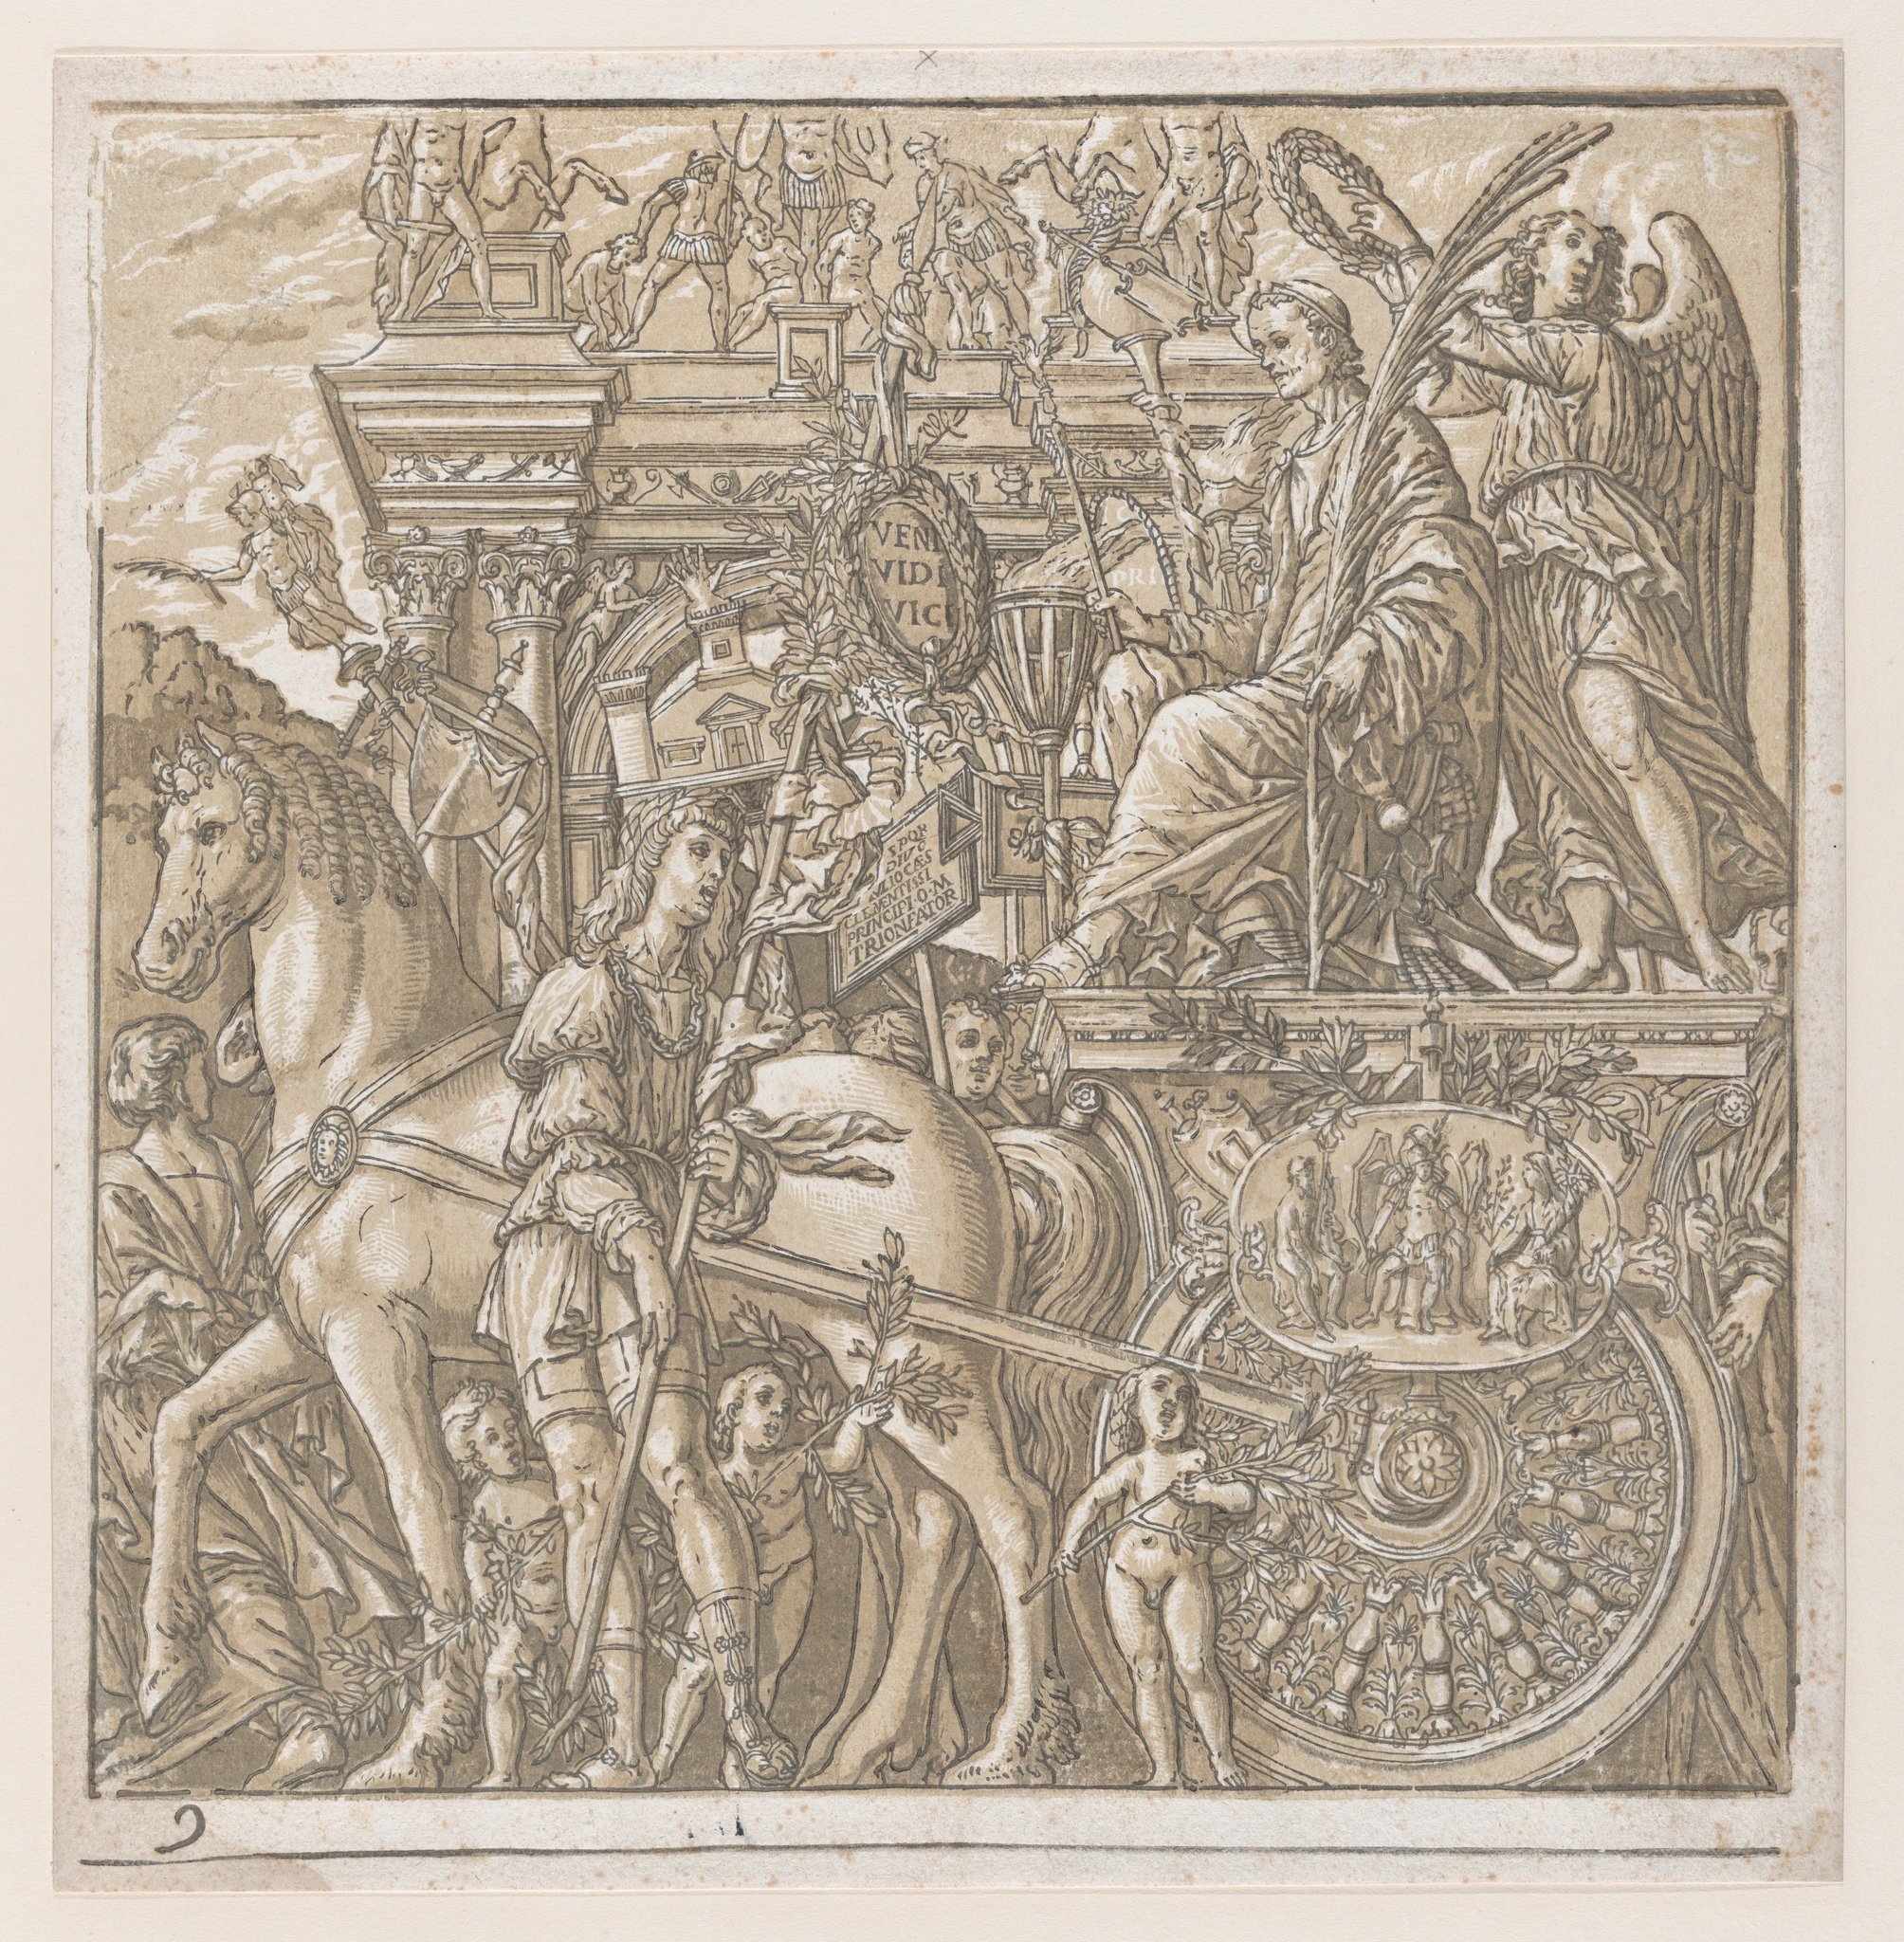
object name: print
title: Sheet 9: Julius Ceasar in his horse-drawn chariot, from "The Triumph of Julius Caesar"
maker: andrea andreani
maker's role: artist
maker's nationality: italian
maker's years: 1558-1629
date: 1599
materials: ink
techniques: woodcut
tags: julius caesar,men,horses,chariots